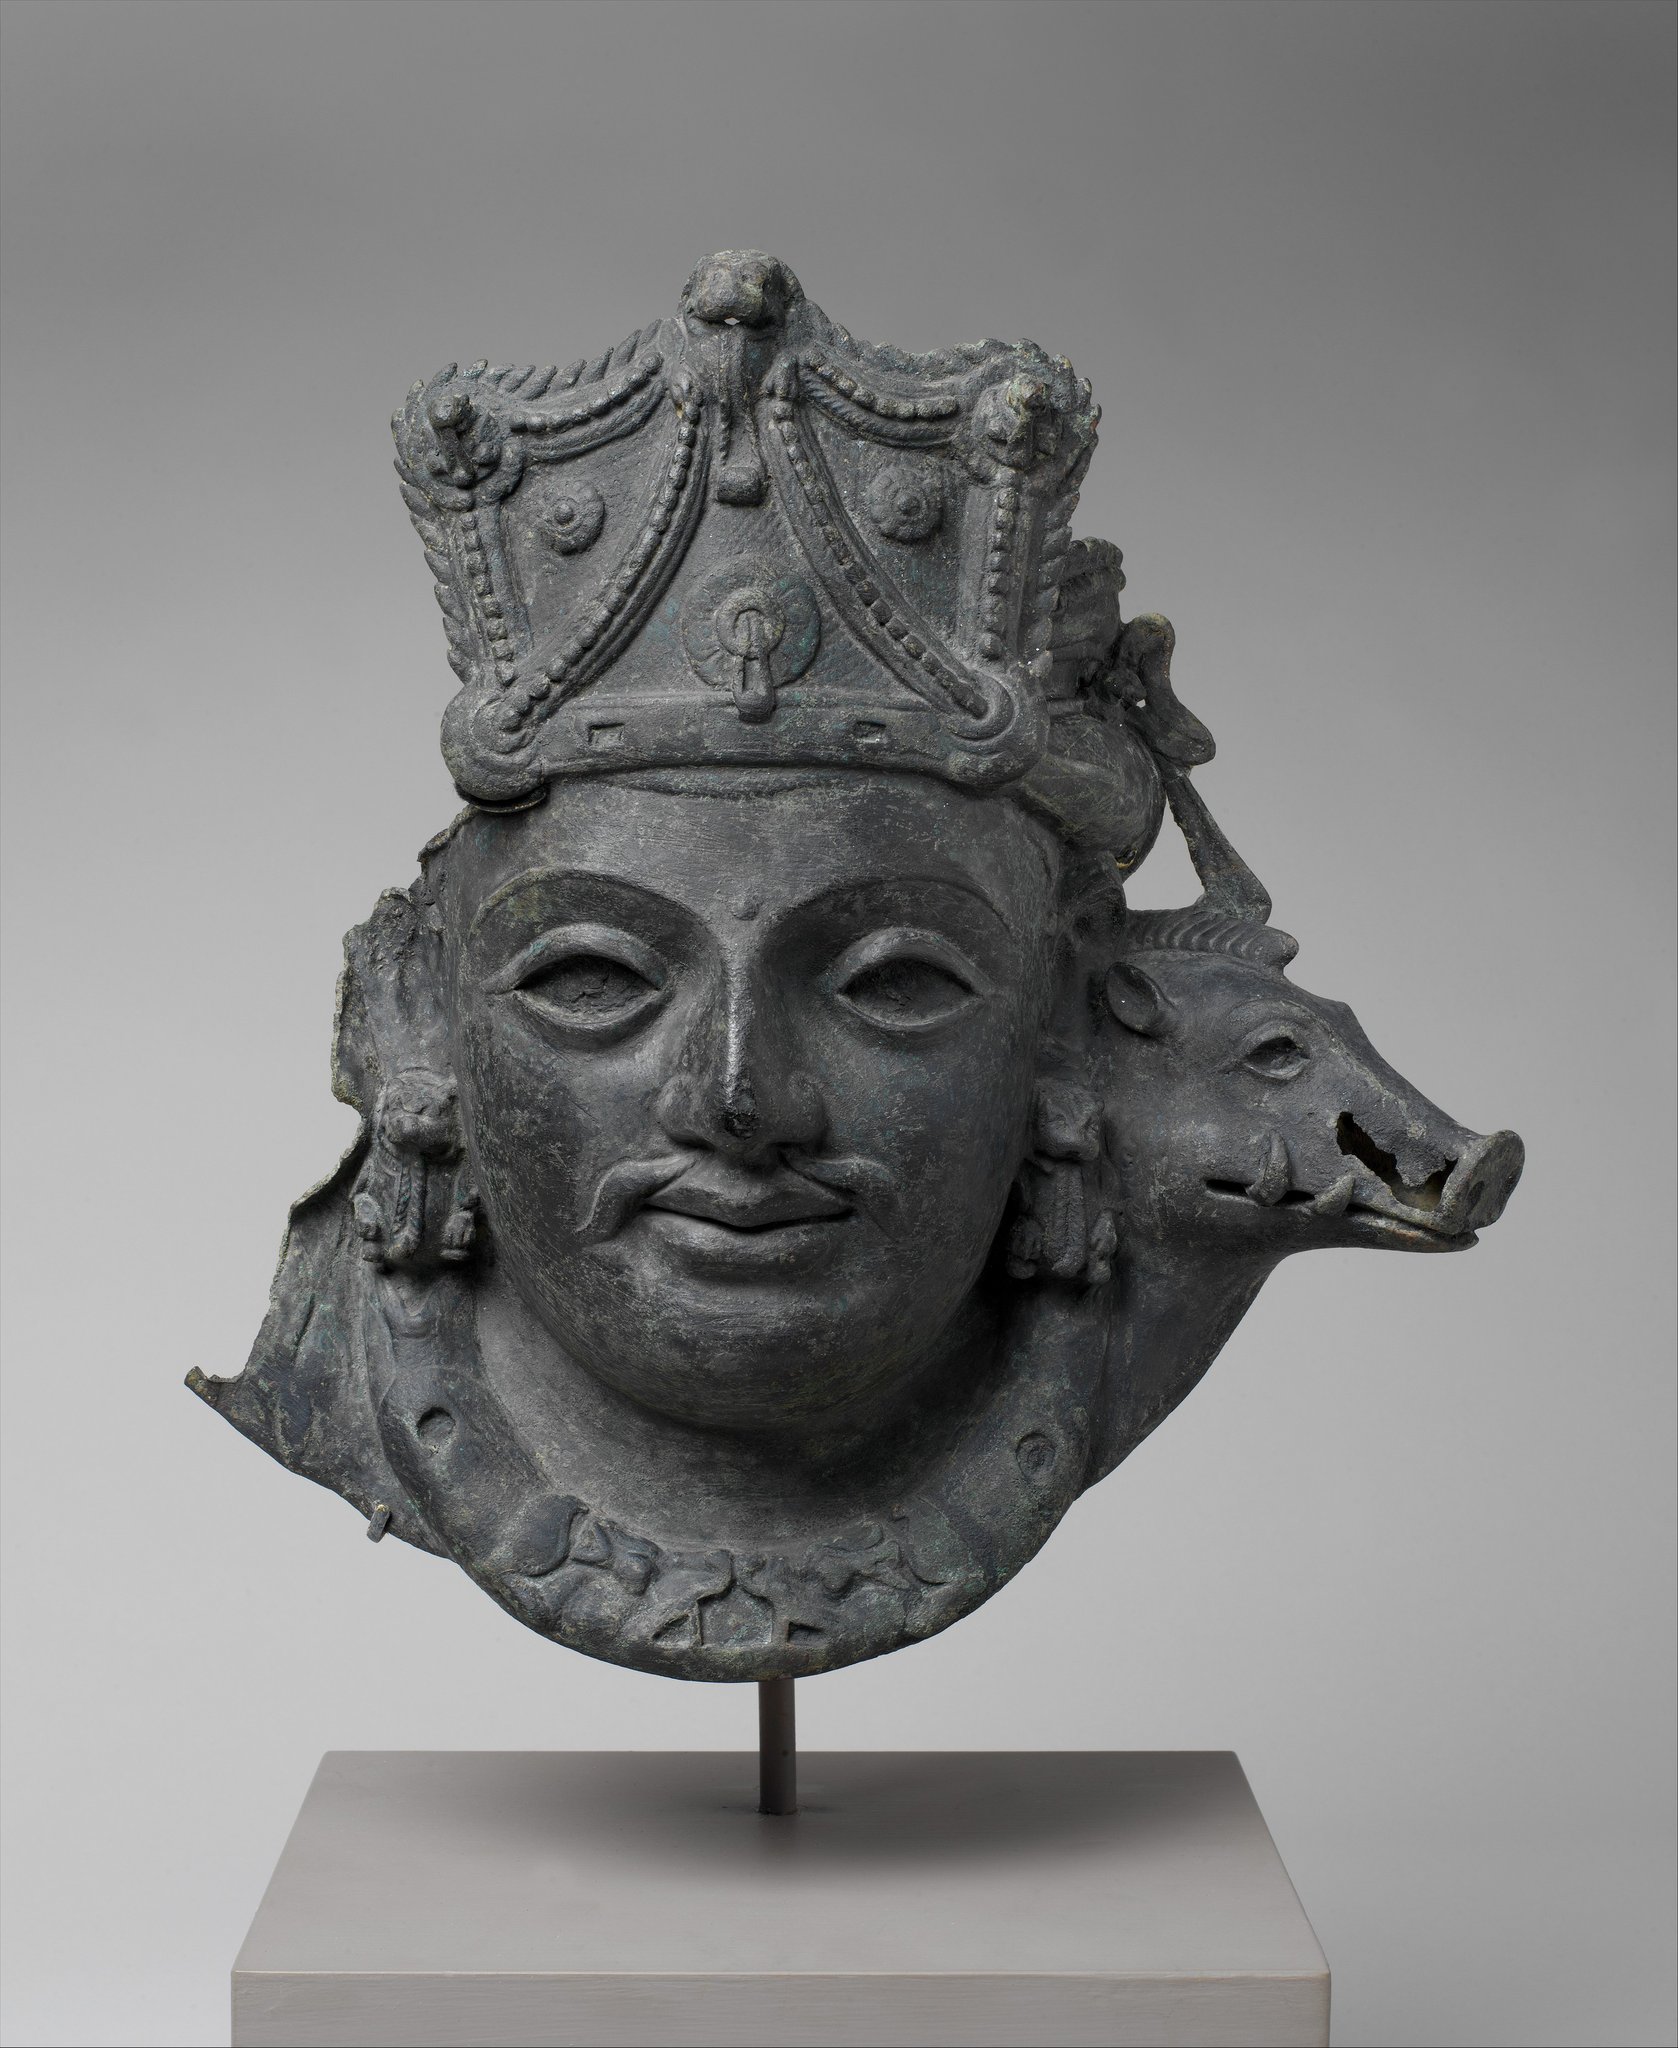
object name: mask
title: Mask of Vaikuntha Vishnu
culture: kashmiri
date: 467-500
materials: bronze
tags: kashmir,boars,vishnu